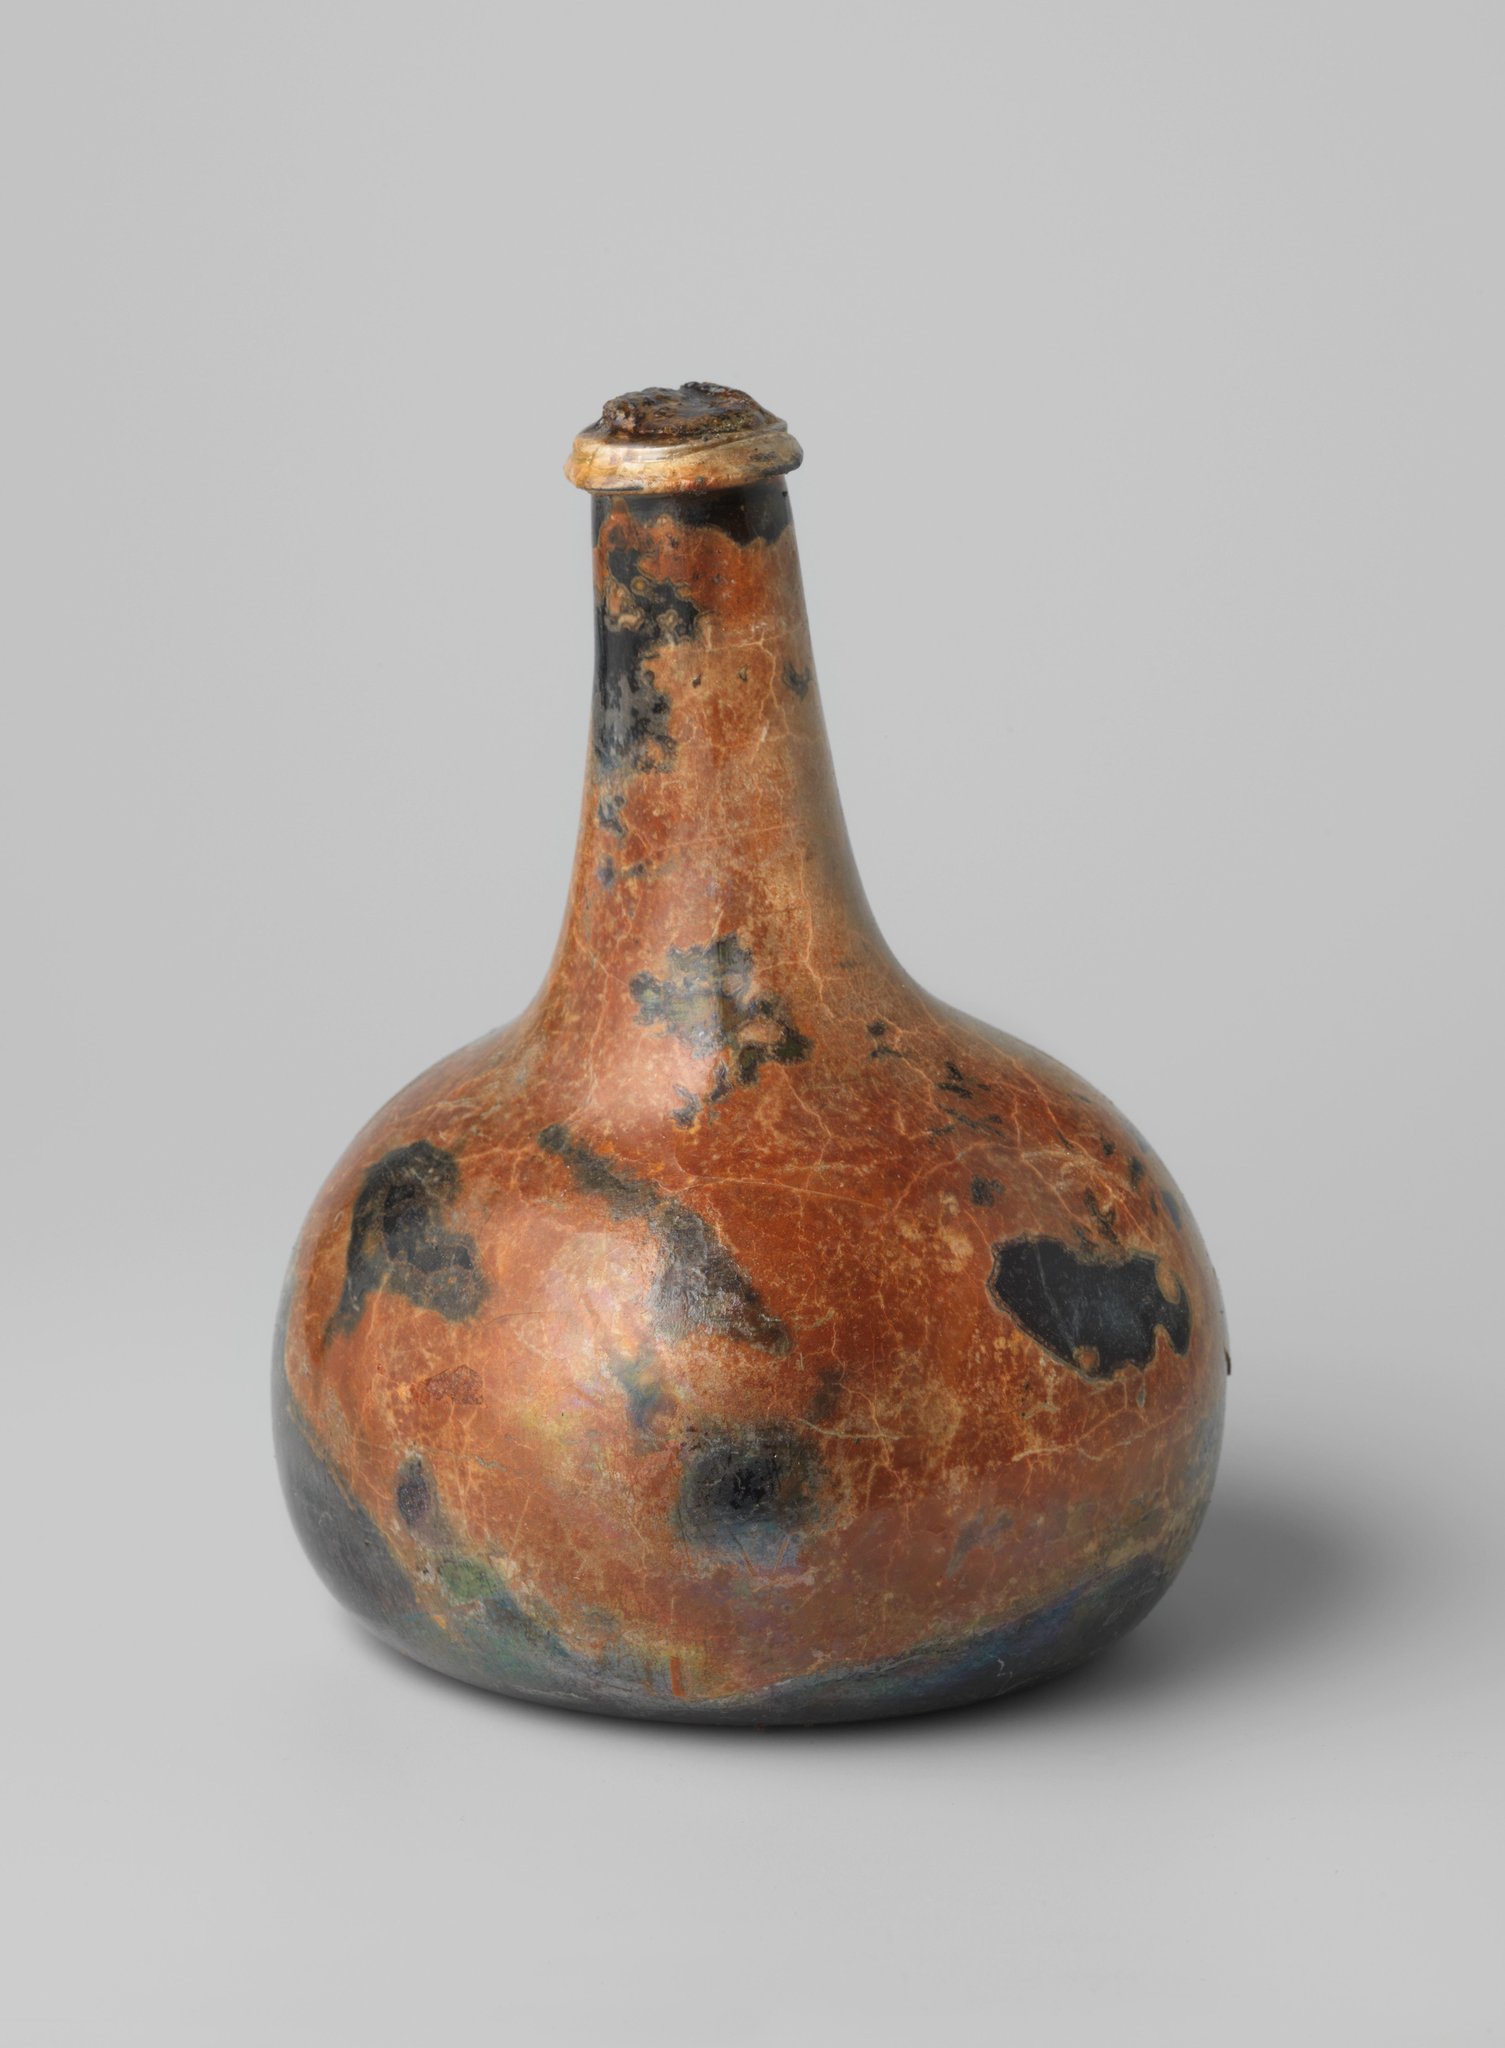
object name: wine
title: Wijnfles met wijn uit het wrak van de Oost-Indiëvaarder 't Vliegend Hart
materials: glass, liquid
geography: netherlands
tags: 't vliegend hart (schip), verenigde oostindische compagnie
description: Uivormige wijnfles van groen glas gevuld met rode (port)wijn, afgesloten met een kurk. De draad die de kurk op de fles moest houden is verdwenen.